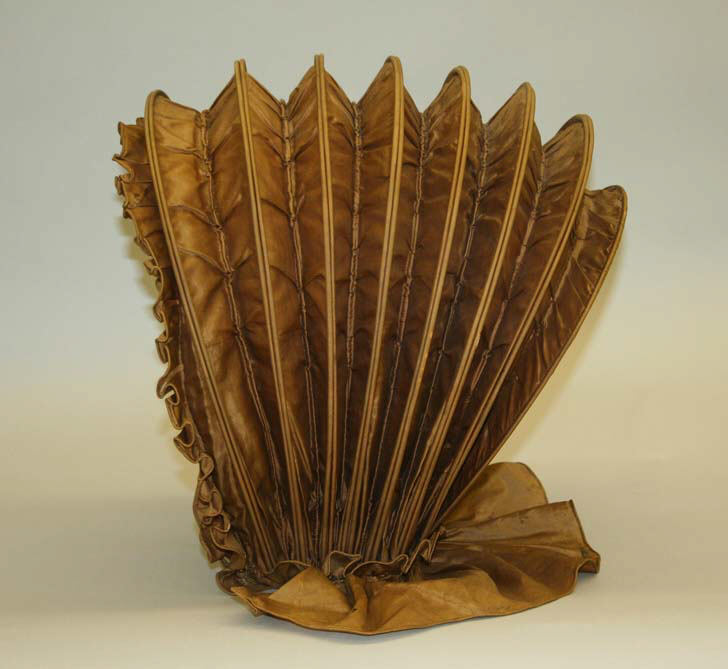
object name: calash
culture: american or european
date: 1775-1785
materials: silk